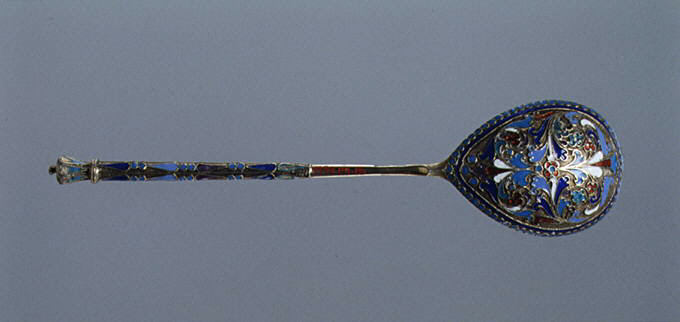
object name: spoon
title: Large, long-handled spoon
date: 1895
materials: enamel, silver